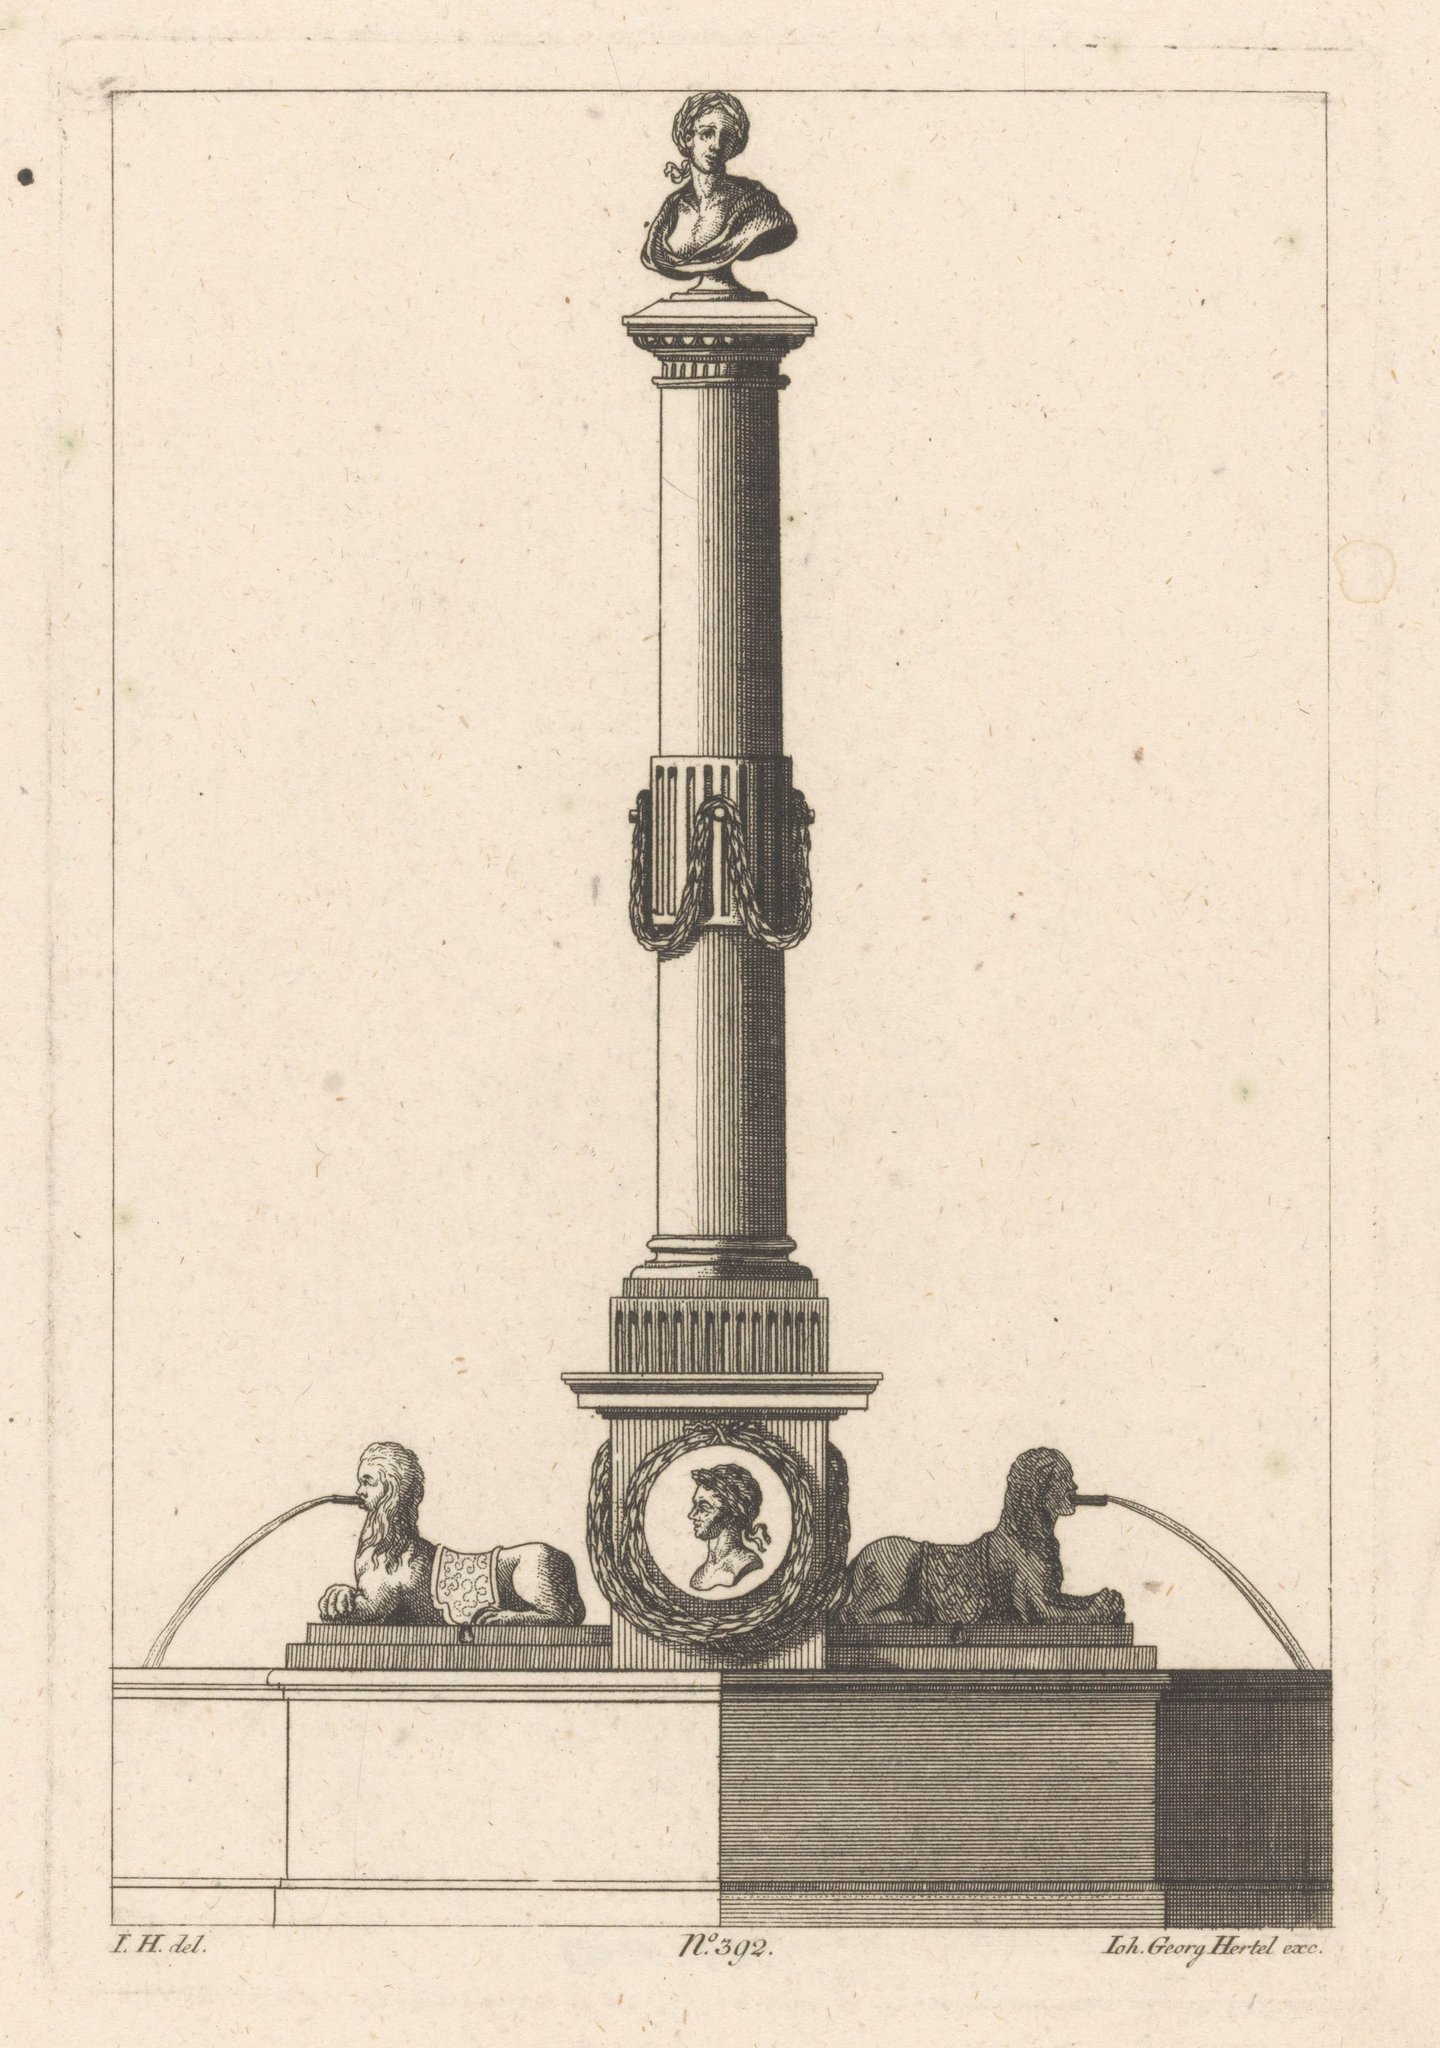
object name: ornament print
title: Fonteinen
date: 1770-1800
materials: paper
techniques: engraving, etching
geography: augsburg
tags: sphinx (lion/woman); 'sfinge' (ripa), ornamental fountain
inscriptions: collector's mark: Lugt 2228, collector's mark: Lugt 2760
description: Ontwerp voor een fontein met twee uitlopers in de vorm van sfinxen. In het midden van de fontein staat een pilaar met buste van een figuur met lauwerkrans en een rond medaillon met gezicht en profil. Uitgeversnummer 392.